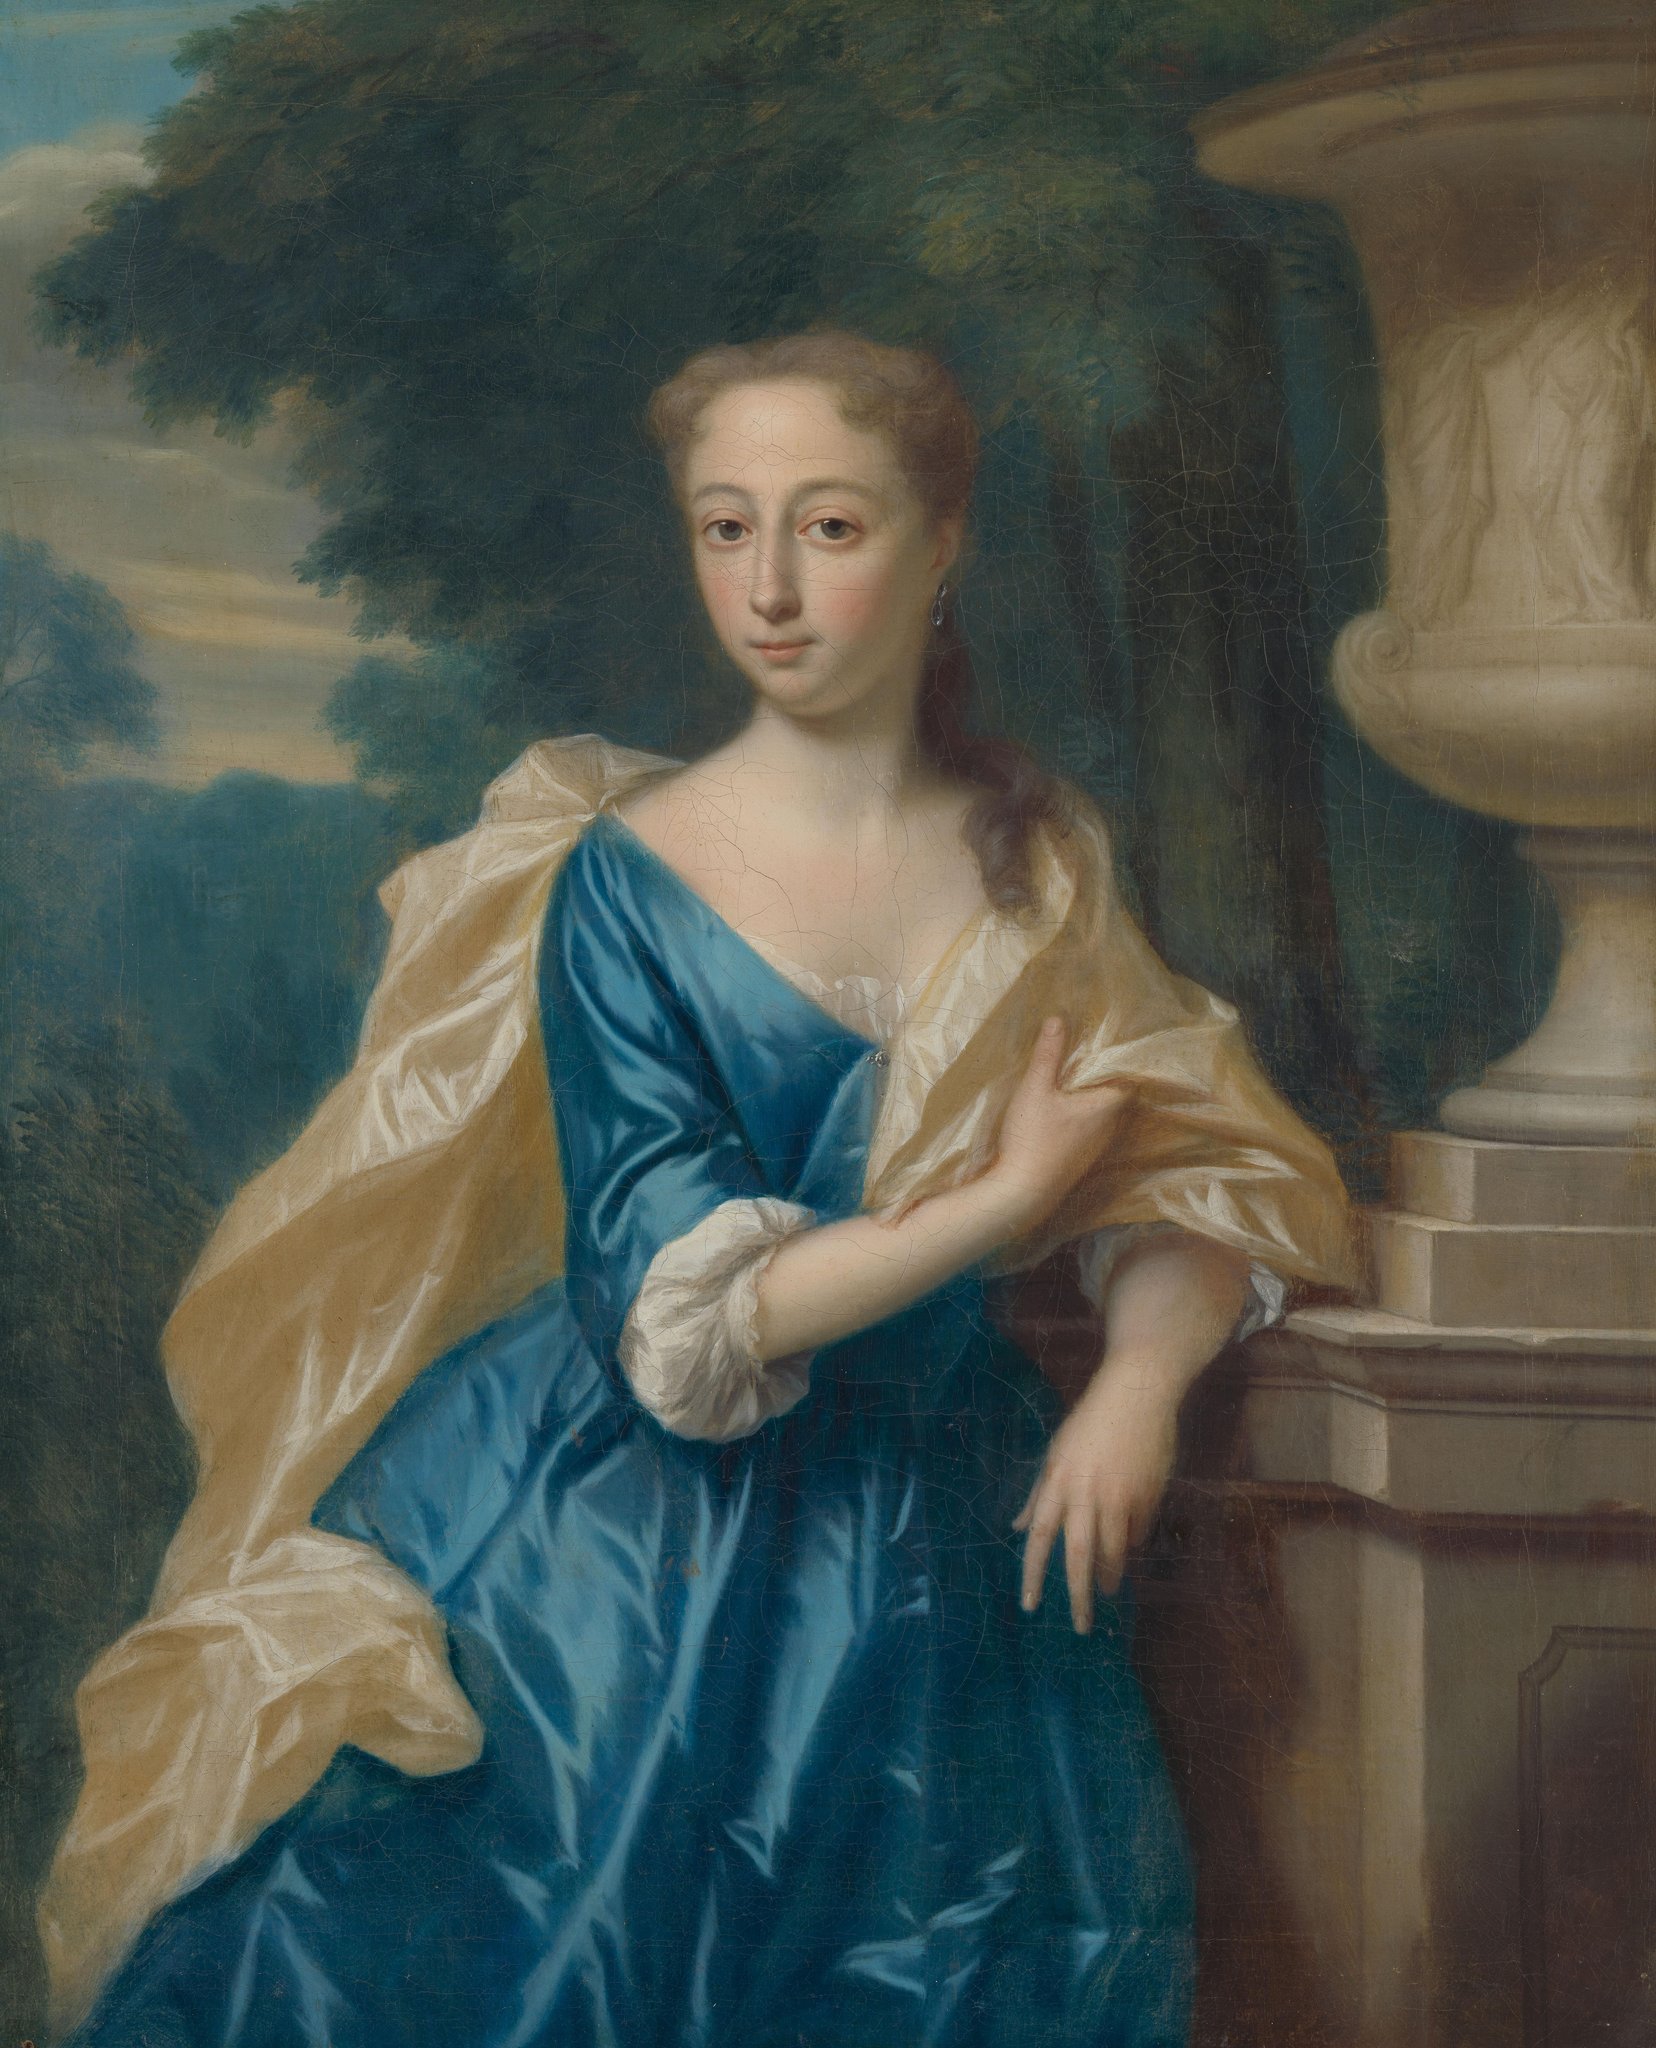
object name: painting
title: Justina Johanna Ramskrammer (1702-98), Wife of Isaac Parker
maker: philip van dijk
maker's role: draughtsman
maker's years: 1683-1753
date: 1734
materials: canvas, oil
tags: historical persons - bb - woman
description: Portret van Justina Johanna Ramskrammer, de echtgenote van Isaac Parker. Kniestuk, staande bij een tuinvaas op een balustrade. Pendant van SK-A-1647.